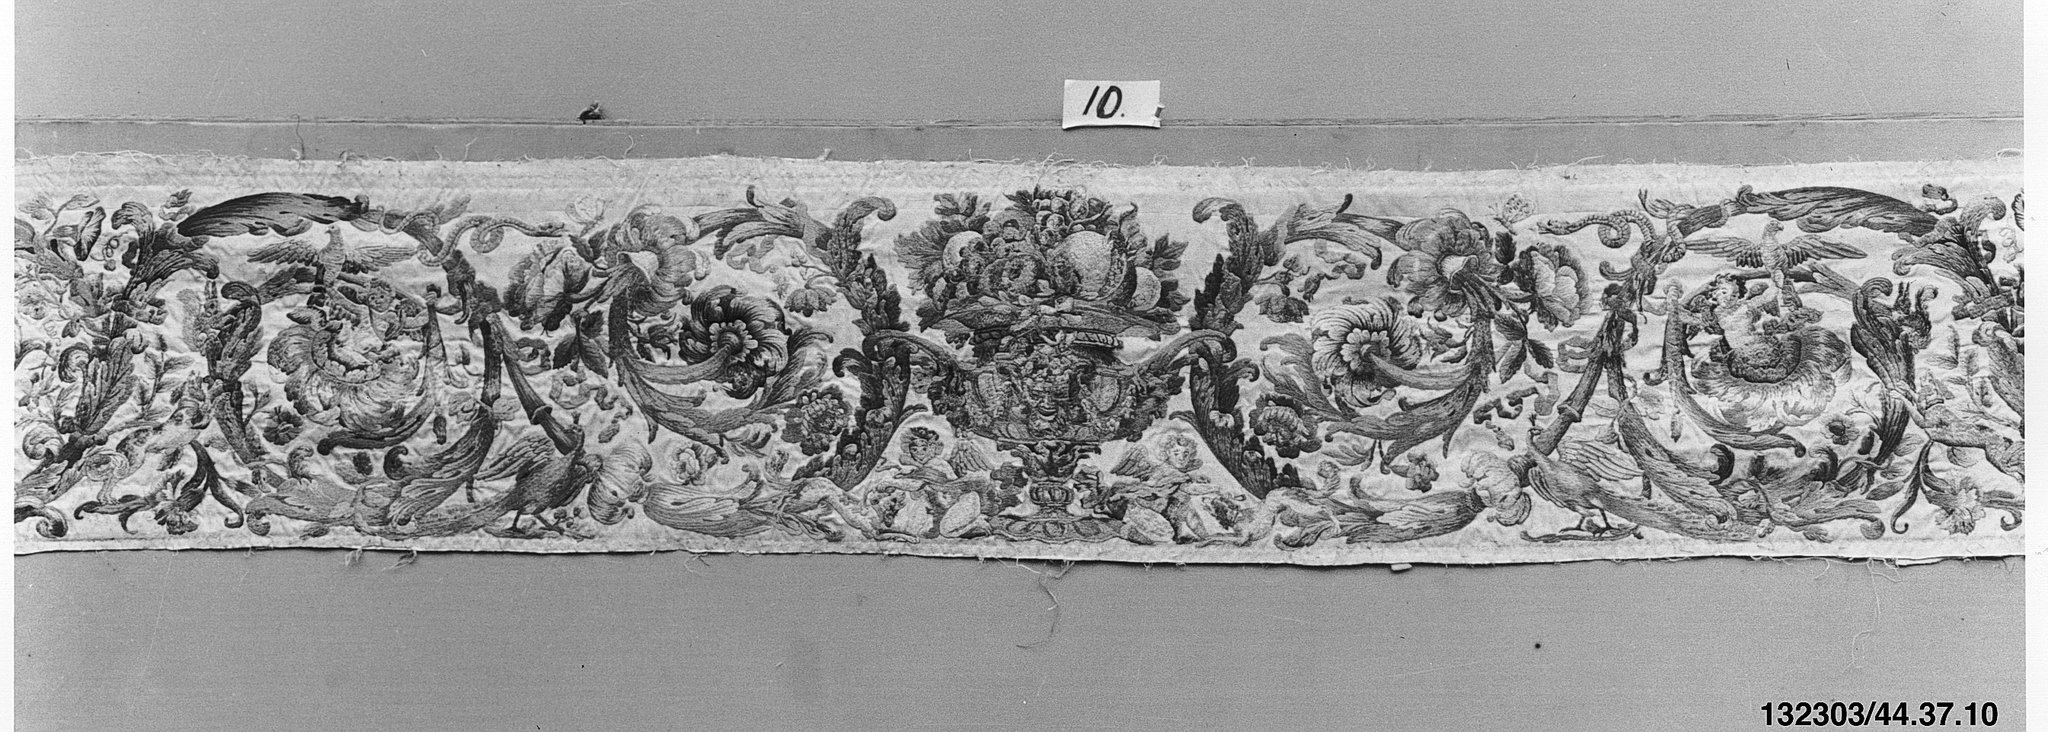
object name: valance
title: Valance (one of a set of six)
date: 1667-1733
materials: silk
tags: peacocks,snakes,flowers